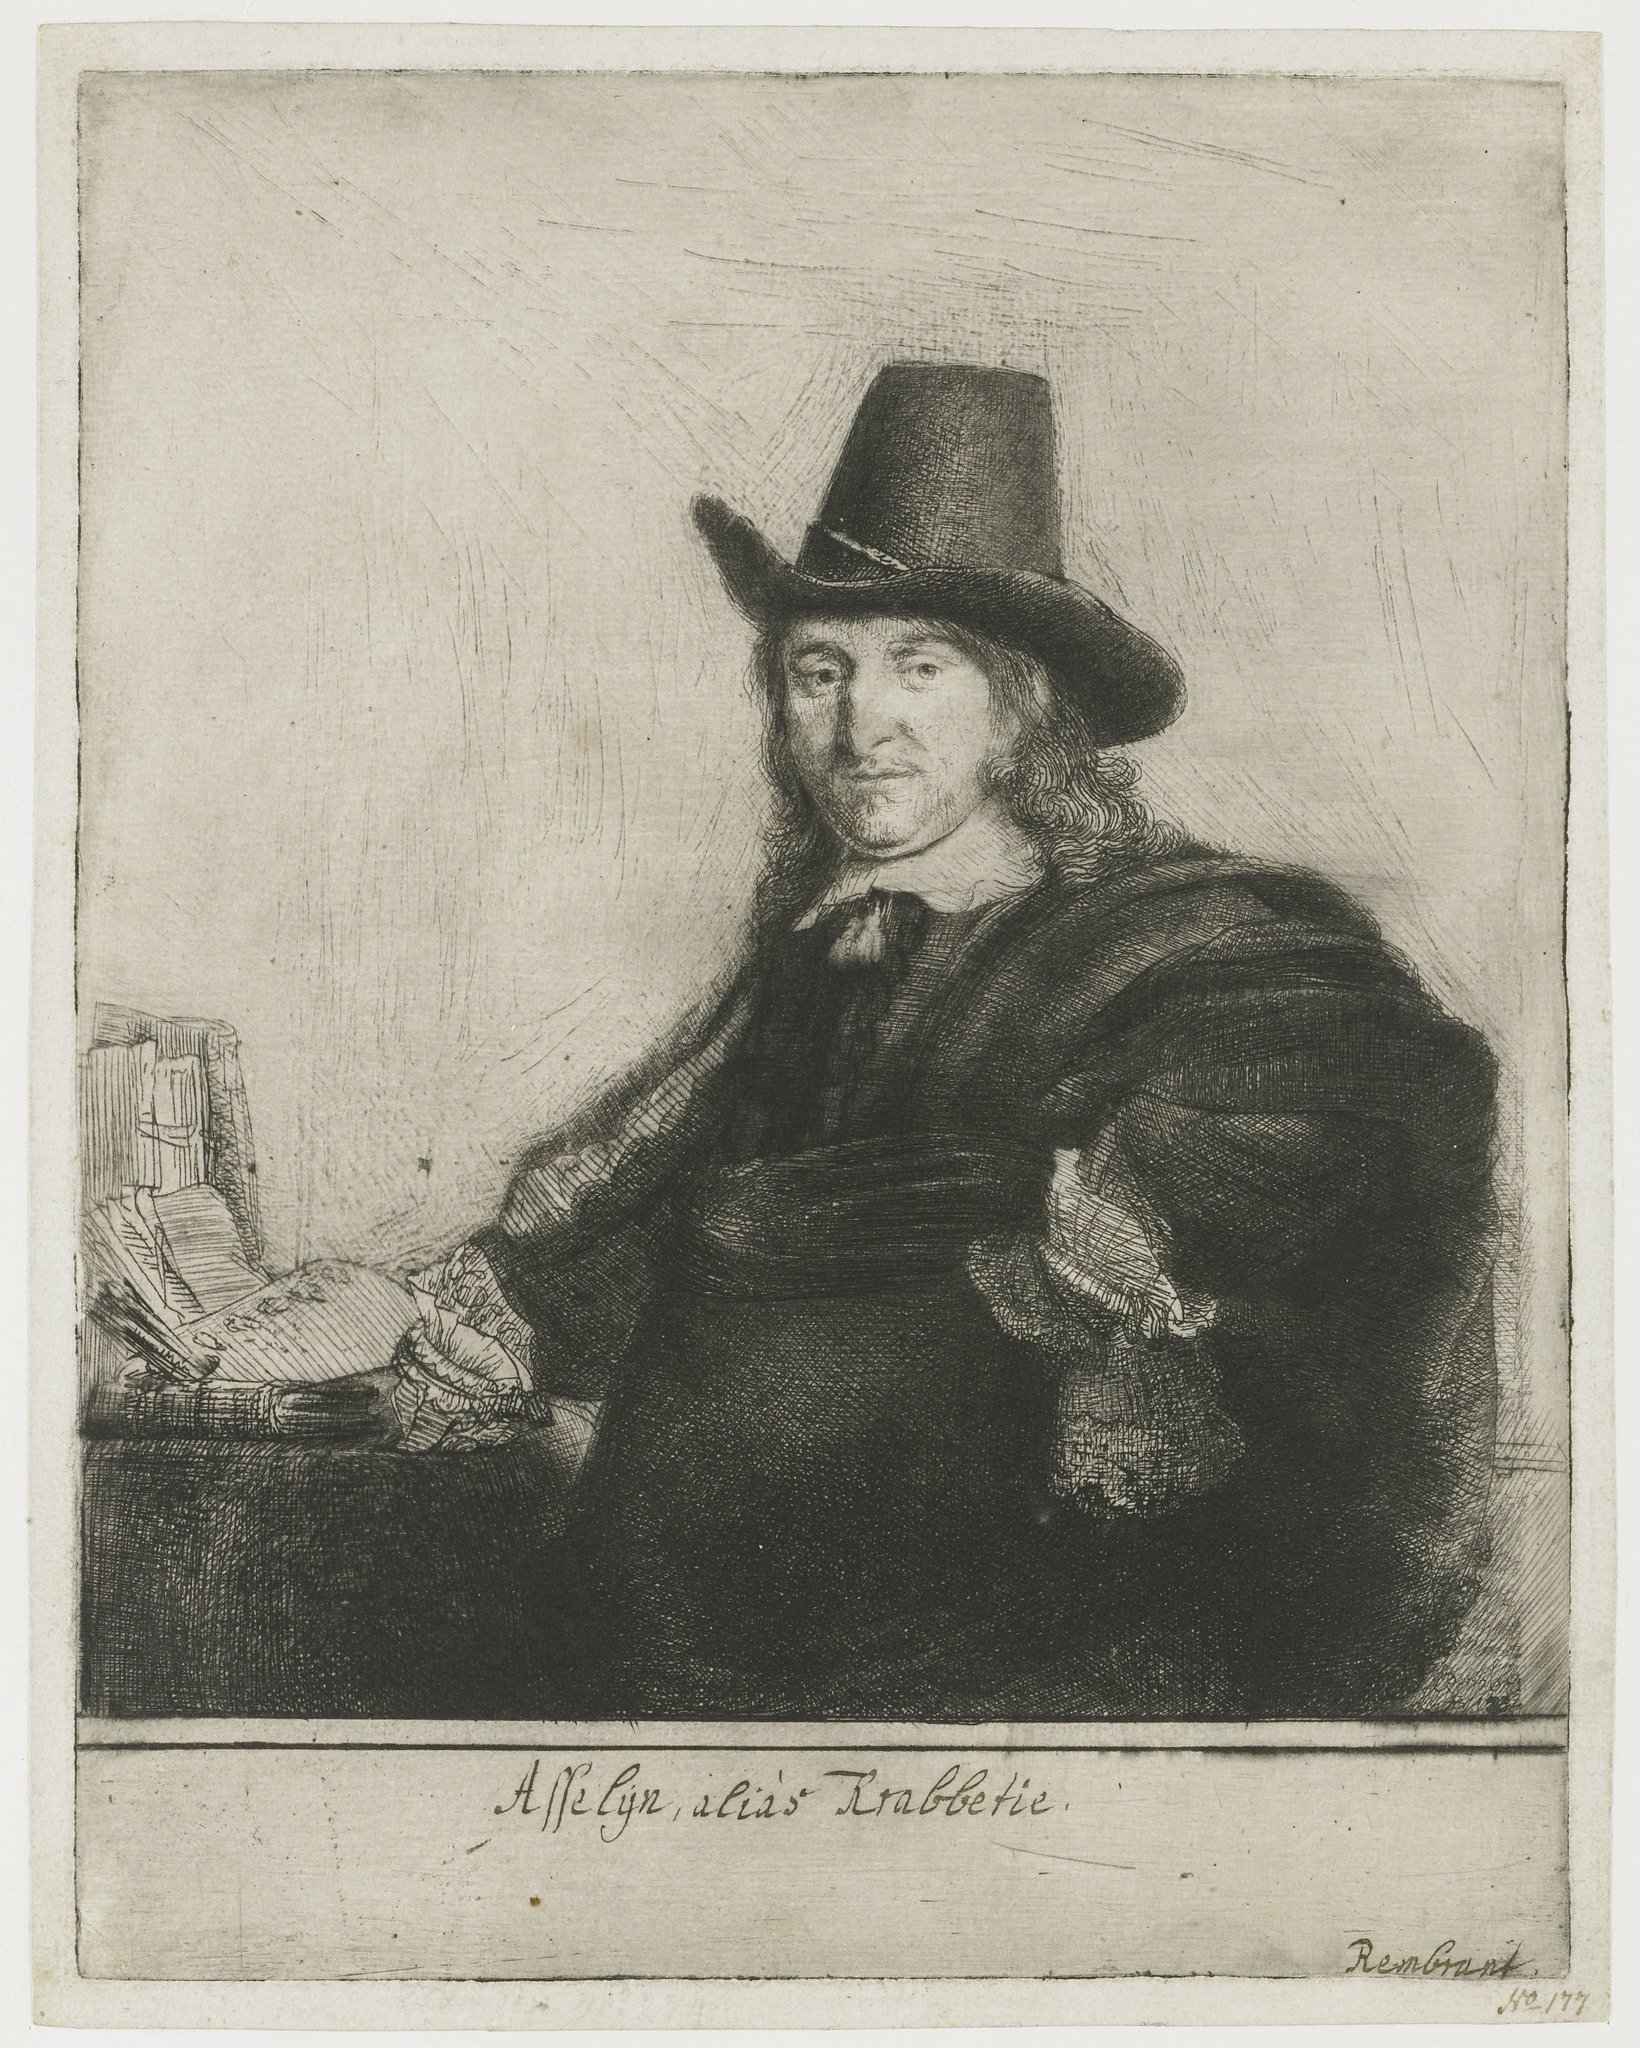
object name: print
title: Jan Asselijn, painter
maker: rembrandt van rijn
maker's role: draughtsman, painter, print maker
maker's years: 1606-1669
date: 1647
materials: paper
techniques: drypoint, etching, intaglio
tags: amsterdam, jan asselijn, portrait, self-portrait of painter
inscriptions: inscription: ‘Asselijn, alias Krabbetie’, mark: Lugt 2228, inscription: ‘No 177’, inscription: ‘2 - 2 .’, mark: Lugt 2632, signature and date: ‘Rembr / f 16’, inscription: ‘Rembrant’, inscription: ‘1887’, inscription: ‘3 fl’